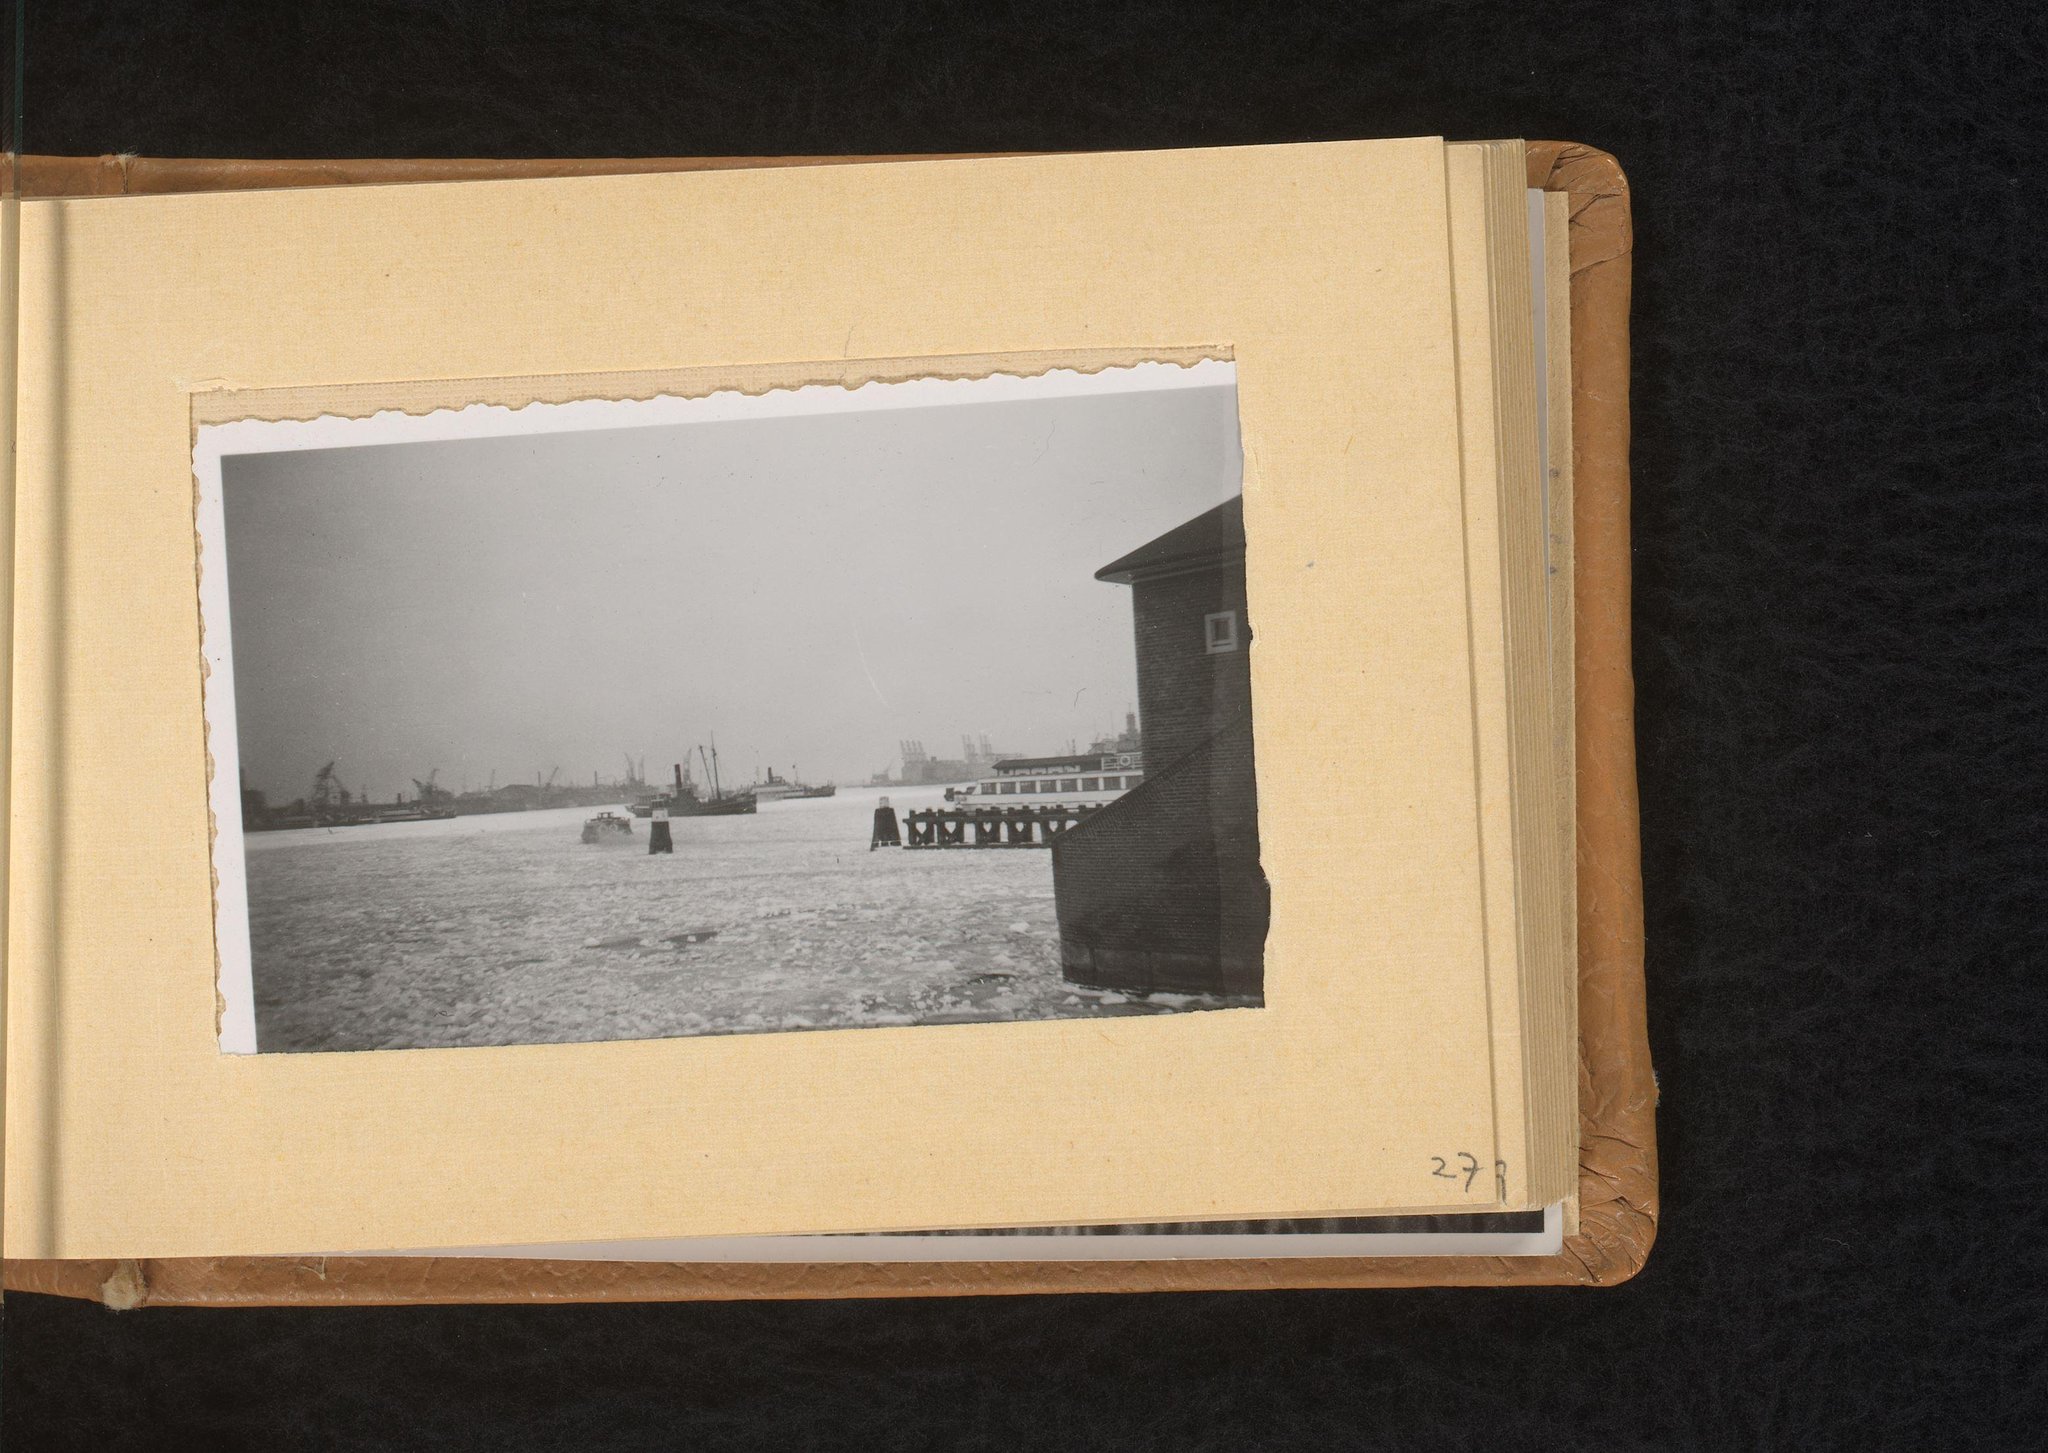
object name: album leaf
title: Haven met schepen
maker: Anonymous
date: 1940-1943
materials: paper, photographic support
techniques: gelatin silver print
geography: netherlands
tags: harbour, occupation ~ war, netherlands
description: Albumblad met een foto van een haven met schepen. Onderdeel van een klein album van de Kriegsmarine in Nederland.